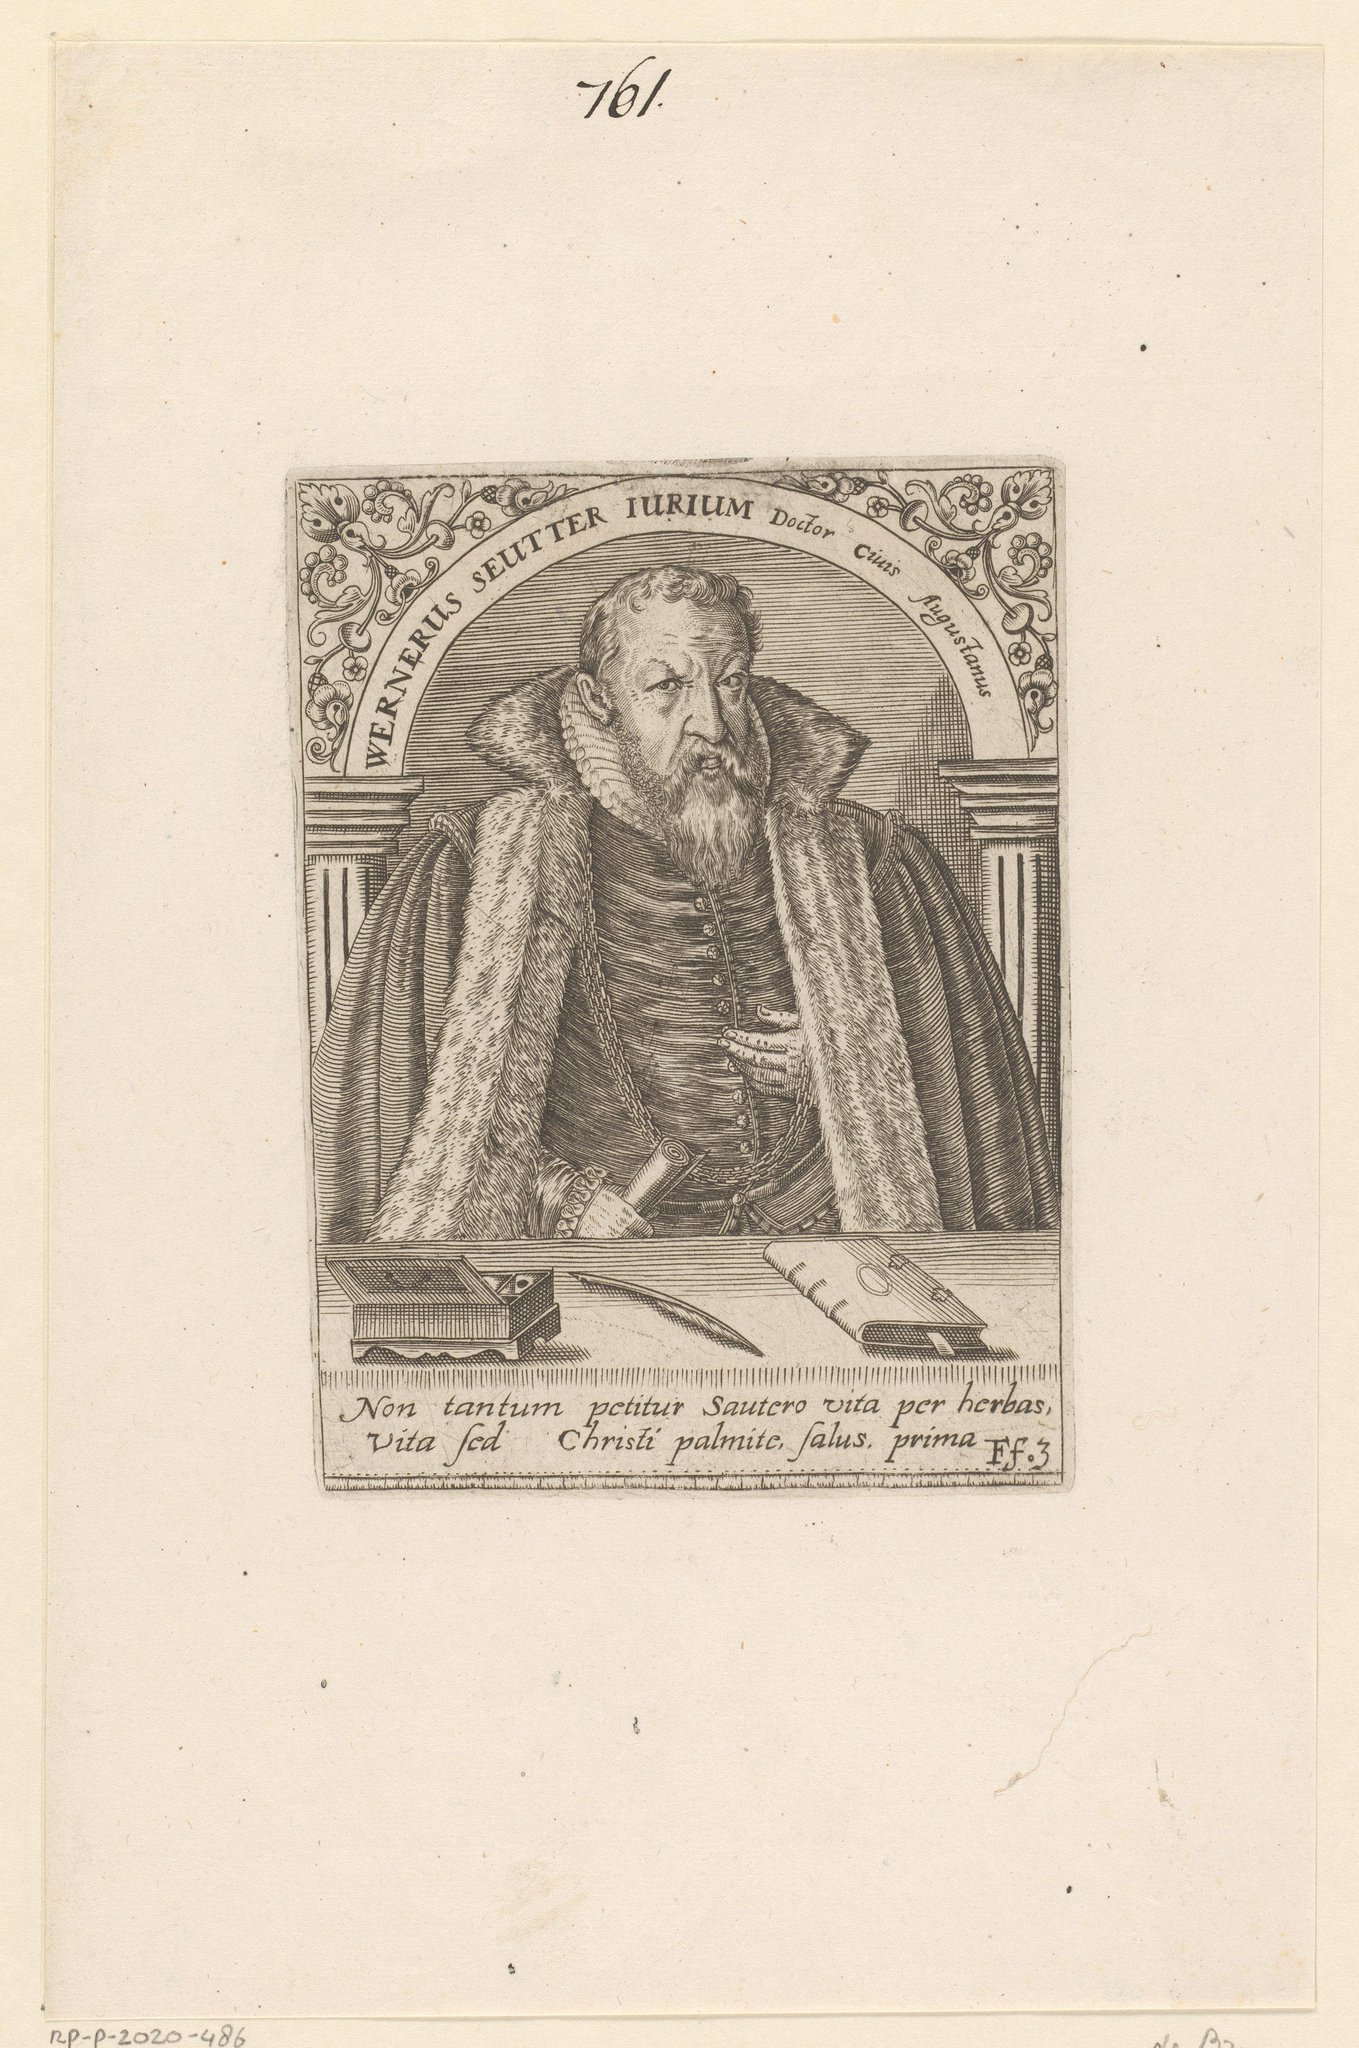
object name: print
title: Portret van Werner Seutter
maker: jean jacques boissard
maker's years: 1528-1598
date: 1650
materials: paper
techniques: engraving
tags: theologian, historical persons, portrait of a musician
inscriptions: inscription: ‘761’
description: Prent gebruikt in: Boissard, Jean Jacques. Bibliotheca chalcographica. 8 dln. Frankfurt am Main: Johannes Ammon, 1650-1652. Ook gebruikt in latere edities. Eerdere staat van prent verschenen in: Boissard, Jean Jacques. Icones quinquaginta virorum illustrium doctrina & eruditione praestantium ad vivum effictae. 4 dln. Frankfurt am Main: s.n., 1597-1599. Mogelijk ook gebruikt in latere edities.